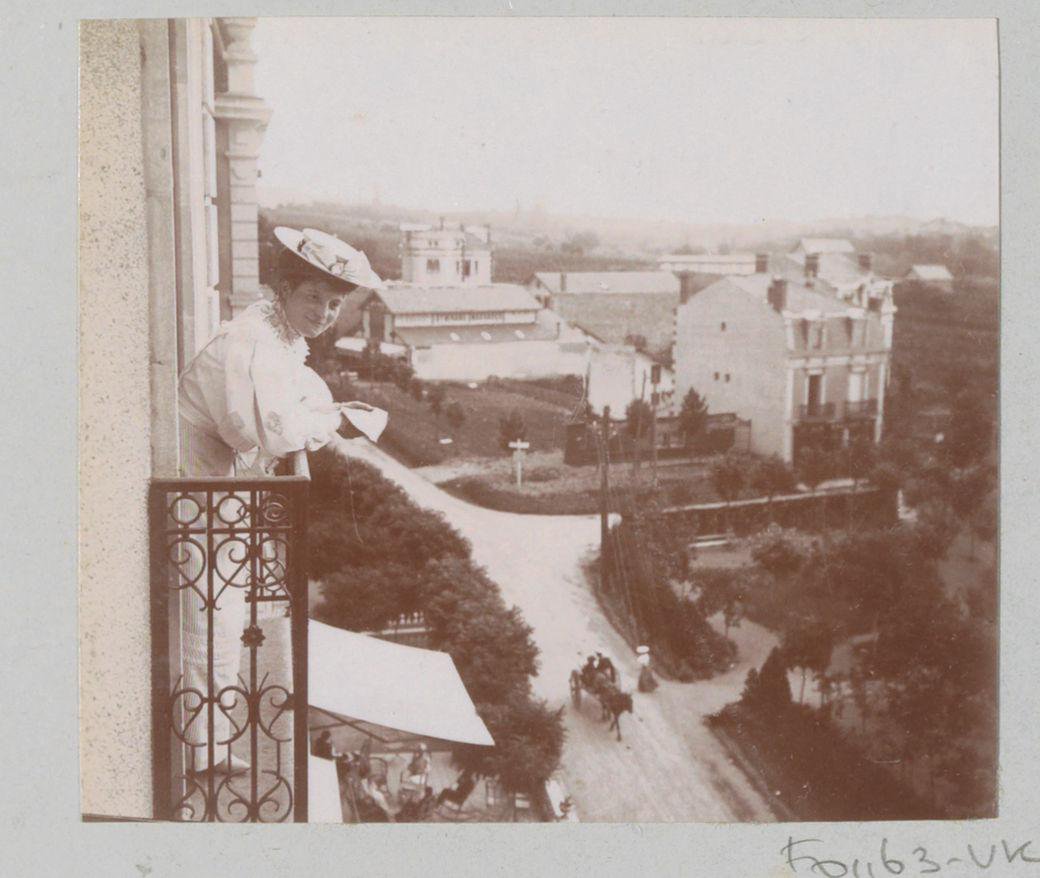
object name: photograph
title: Vrouw kijkt vanaf balkon uit over (vermoedelijk) Châtel-Guyon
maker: delizy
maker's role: manufacturer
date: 1904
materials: paper, photographic support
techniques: gelatin silver print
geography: châtel-guyon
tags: prospect of village, silhouette of village, adult woman, balcony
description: Onderdeel van Fotoalbum van een Franse amateurfotograaf met opnames van uitstapjes in Frankrijk, Spanje, België, Luxemburg en Nederland, de eerste automobielen en autoraces.